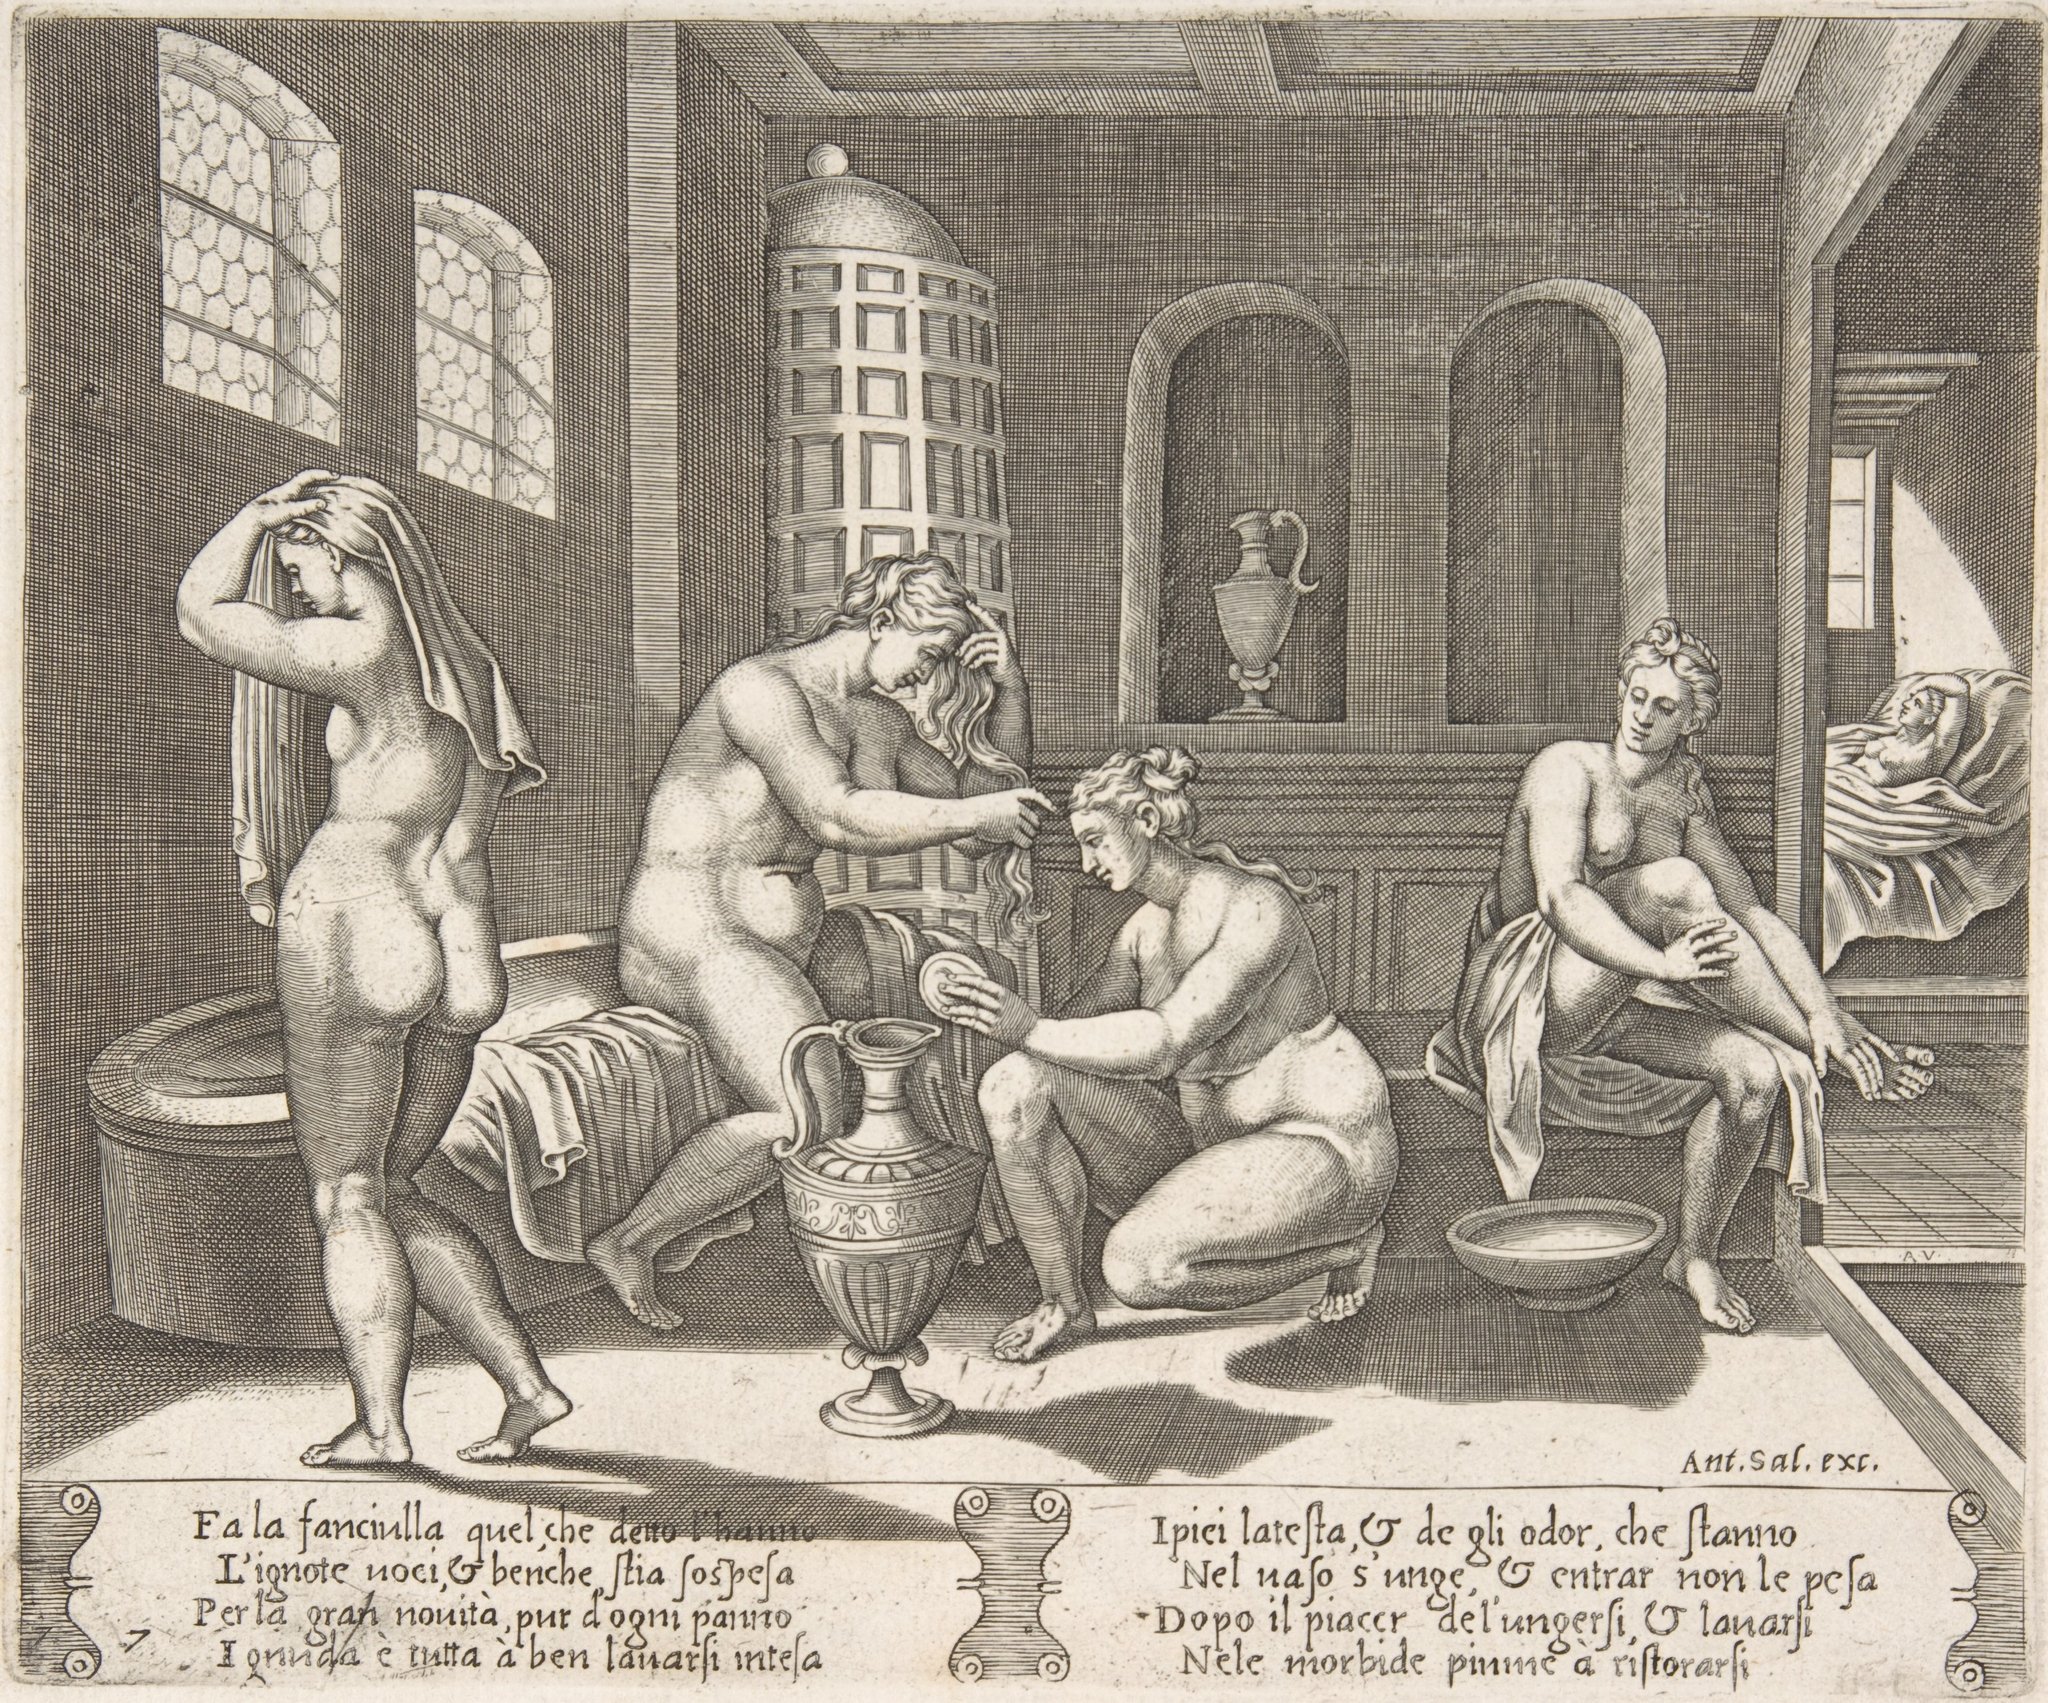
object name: book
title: Story of Cupid and Psyche as told by Apuleius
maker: master of the die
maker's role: artist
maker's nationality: italian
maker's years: 1525-1560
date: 1530-1560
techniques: engraving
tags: cupid,psyche,bathing